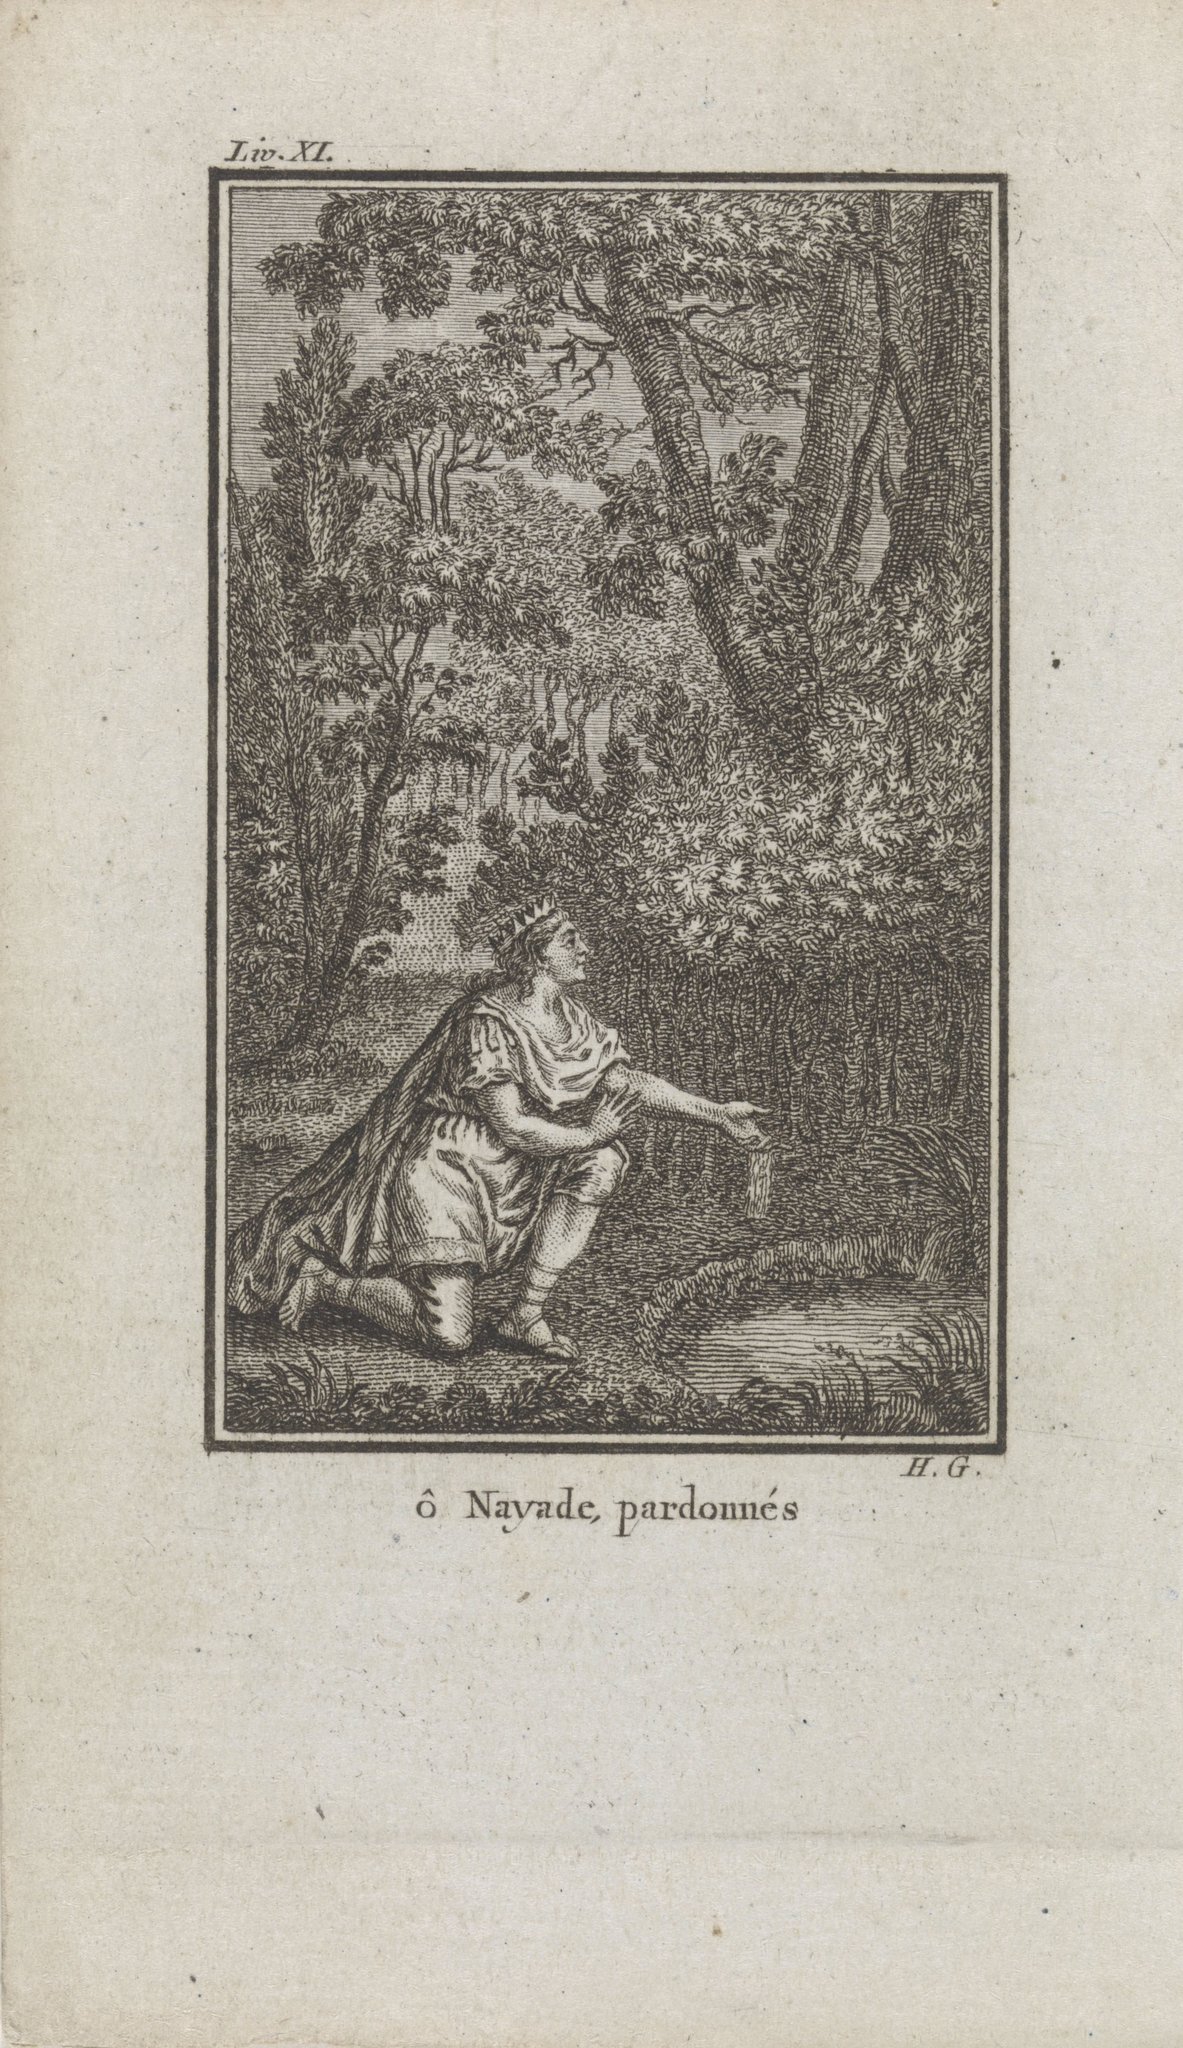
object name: book illustration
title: Koning Numa vindt de heilige bron van de nimf Egeria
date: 1790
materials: paper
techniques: engraving, letterpress printing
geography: brussels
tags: naiads, river- and spring-nymphs; usually carrying an urn; 'naiadi, ninfe de' fiumi' (ripa), spring, source of river or stream, male literary characters (with name)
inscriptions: collector's mark: Lugt 2228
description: Koning Numa knielt voor de heilige bron van de nimf Egeria en vraagt luidop of hij van het water mag drinken. Met een Frans onderschrift.